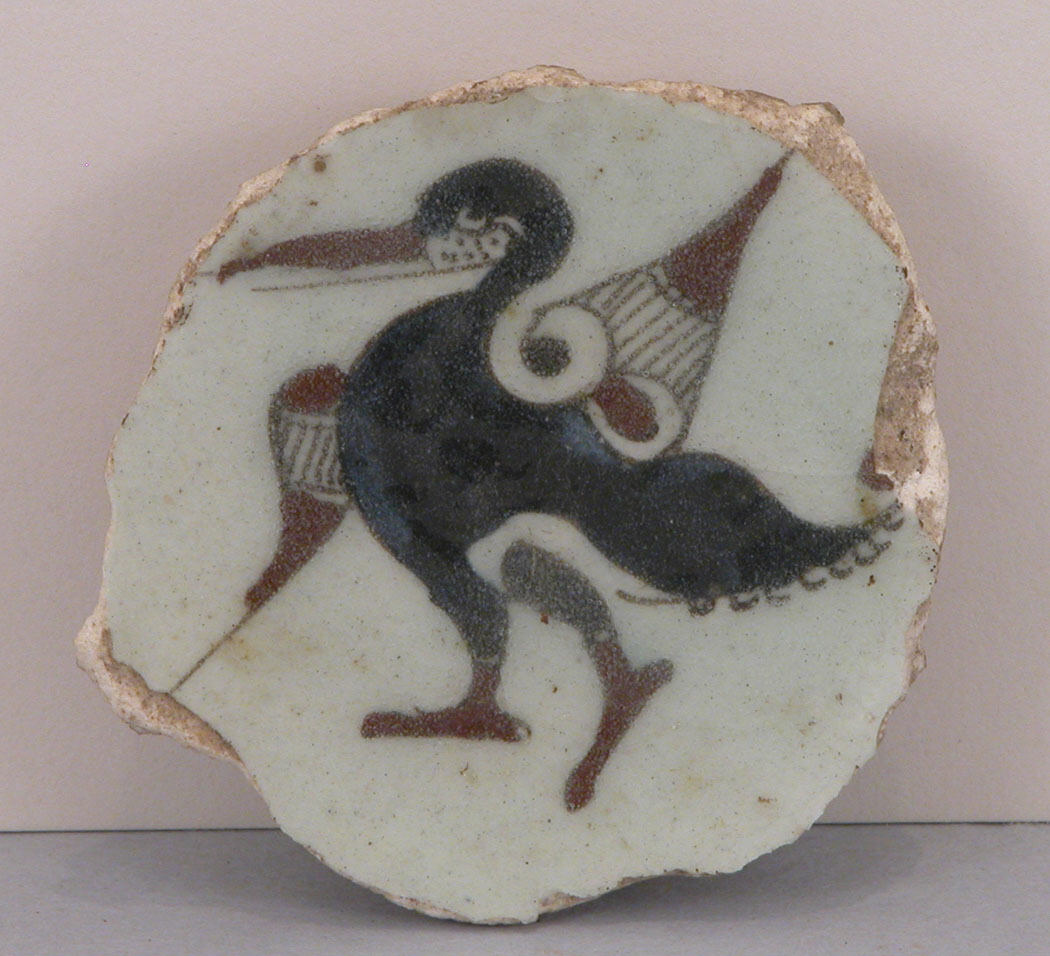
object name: fragment of a bowl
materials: stonepaste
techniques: painting, underglaze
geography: syria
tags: birds